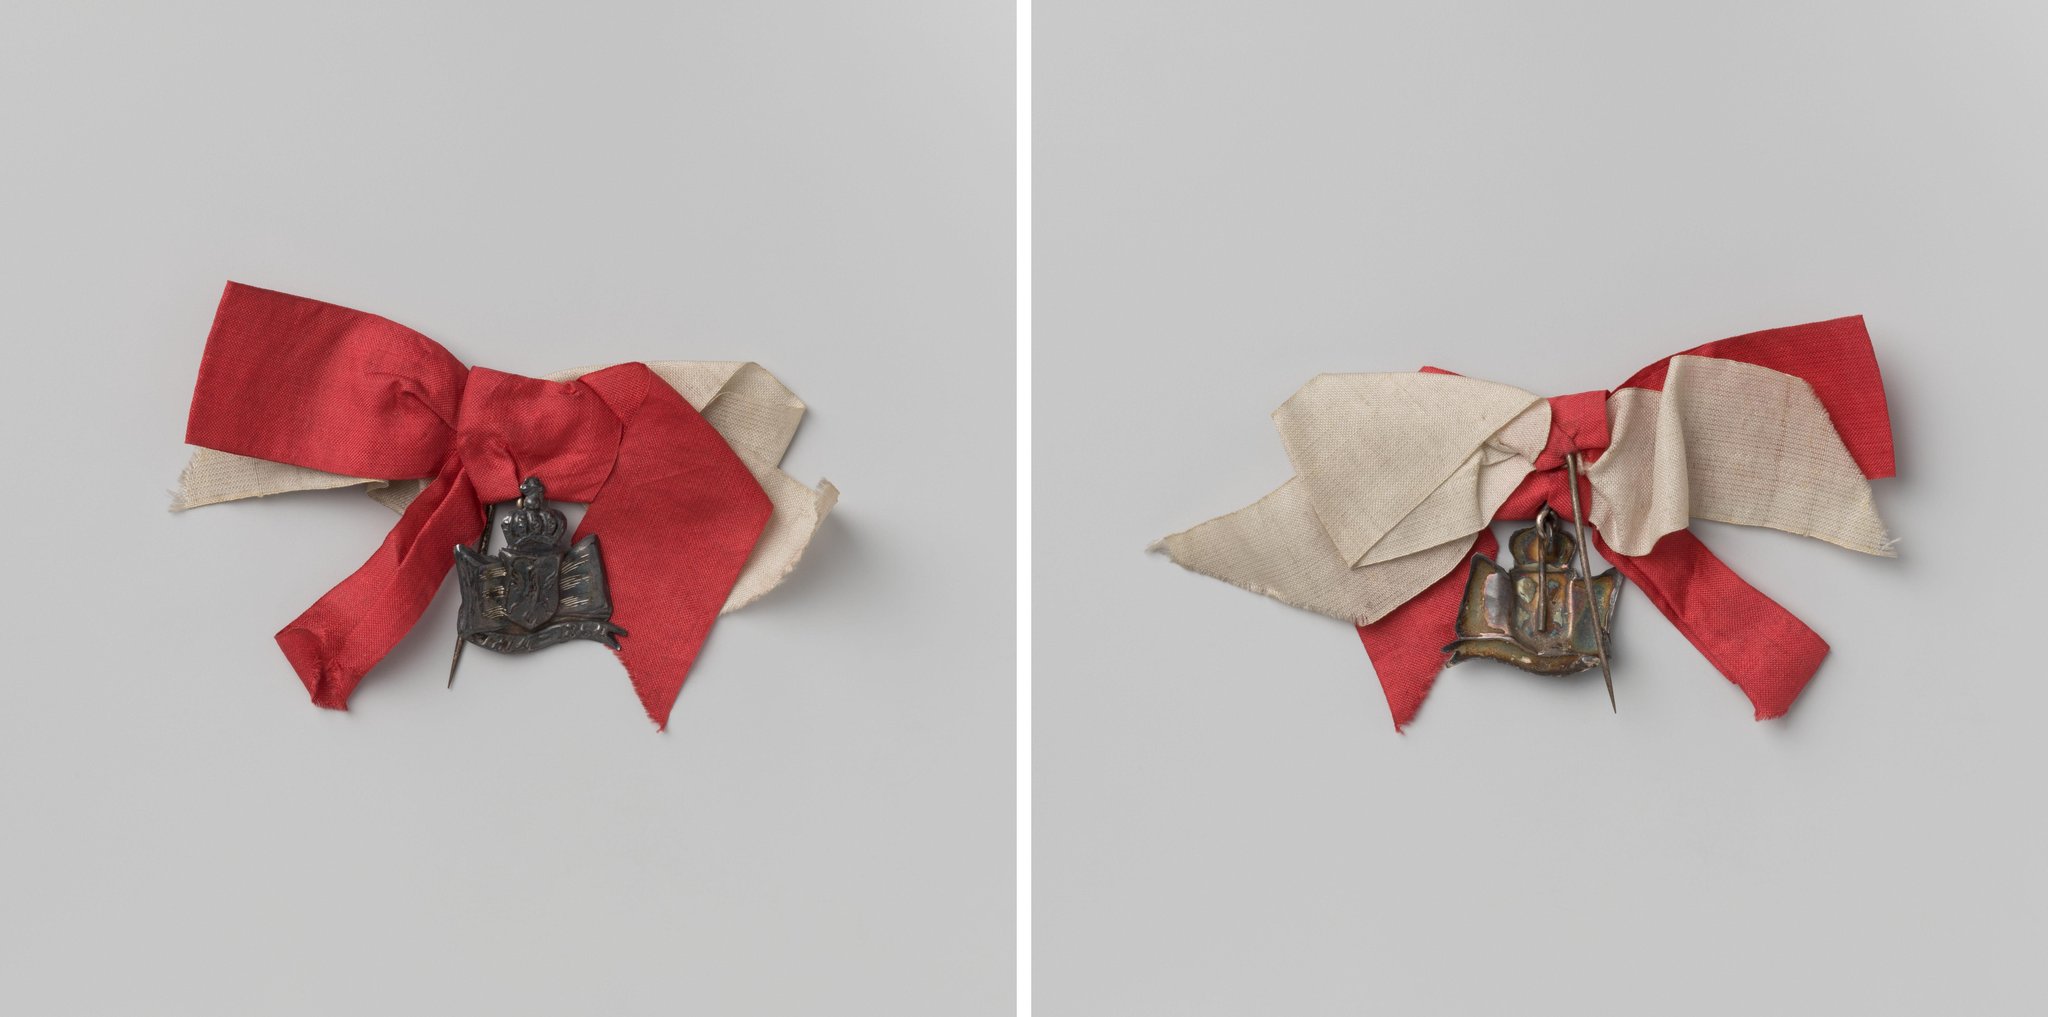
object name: insignia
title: Vijftigjarige viering van de bevrijding van Deventer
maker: Anonymous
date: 1864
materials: silver, textile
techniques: striking, weave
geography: netherlands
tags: deventer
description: Eenzijdig zilveren draagteken aan draagoog en rood-witte strik; daaraan: gekroond wapenschild met aan weerszijden stralen [?] boven lint met jaartallen